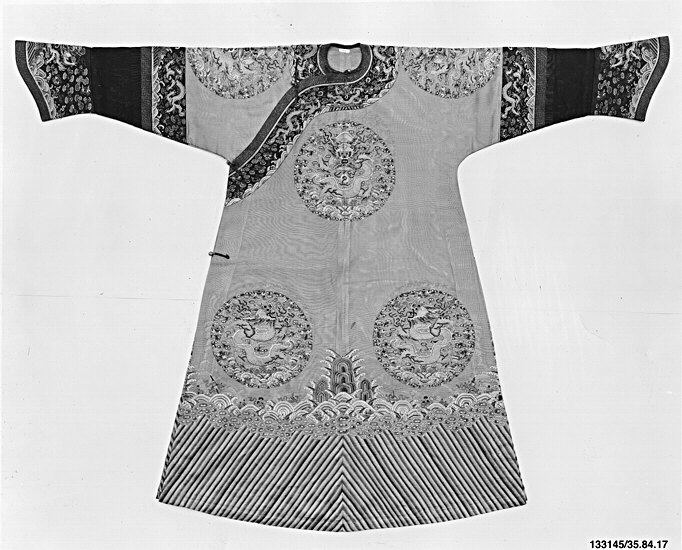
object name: robe, imperial court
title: Imperial Court Robe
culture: chinese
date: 1801-1833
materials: metal thread, silk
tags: dragons